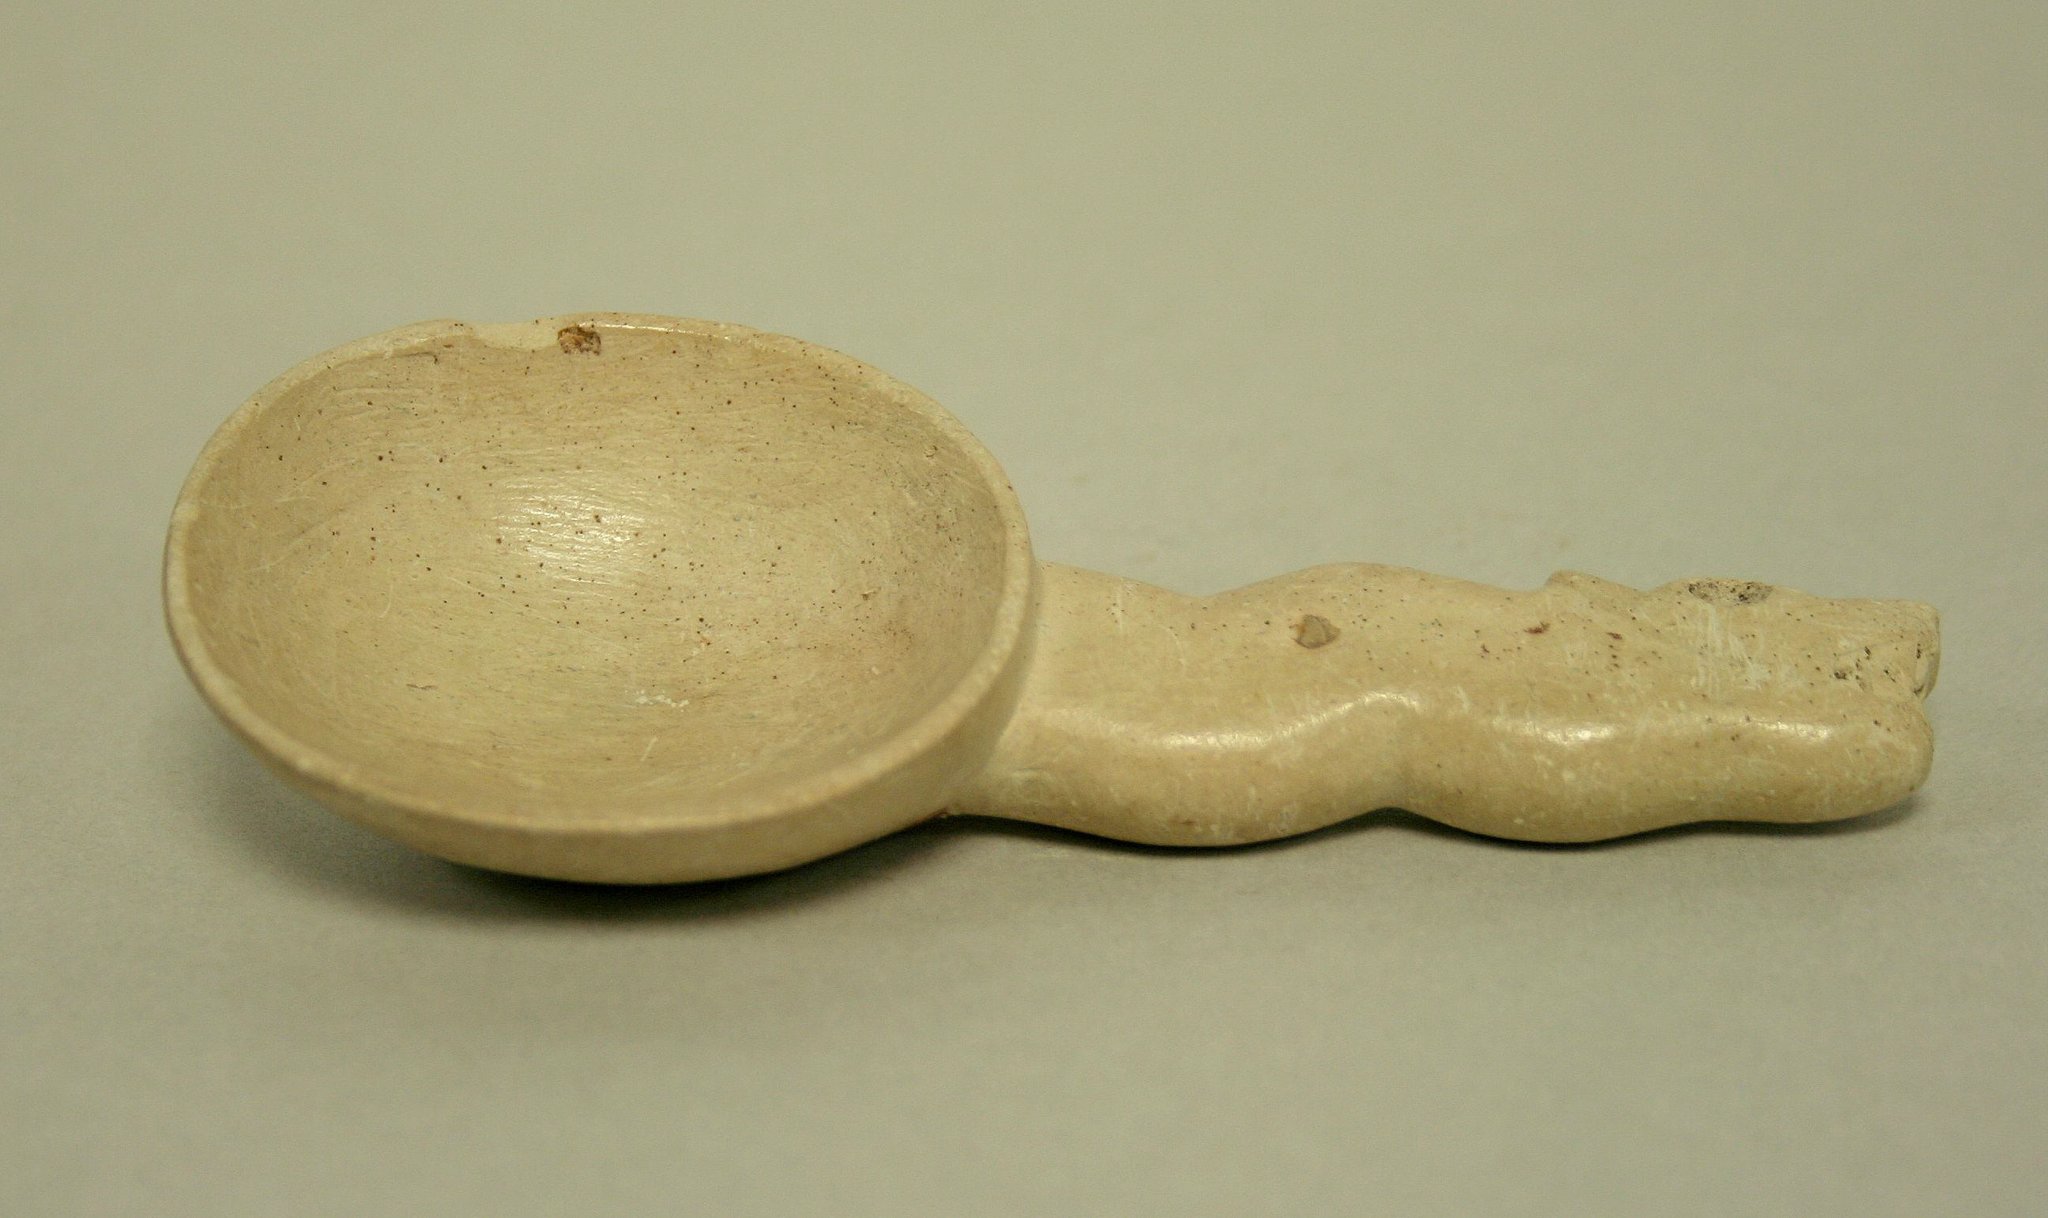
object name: spoon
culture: chavin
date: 700-101 BCE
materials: stone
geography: peru